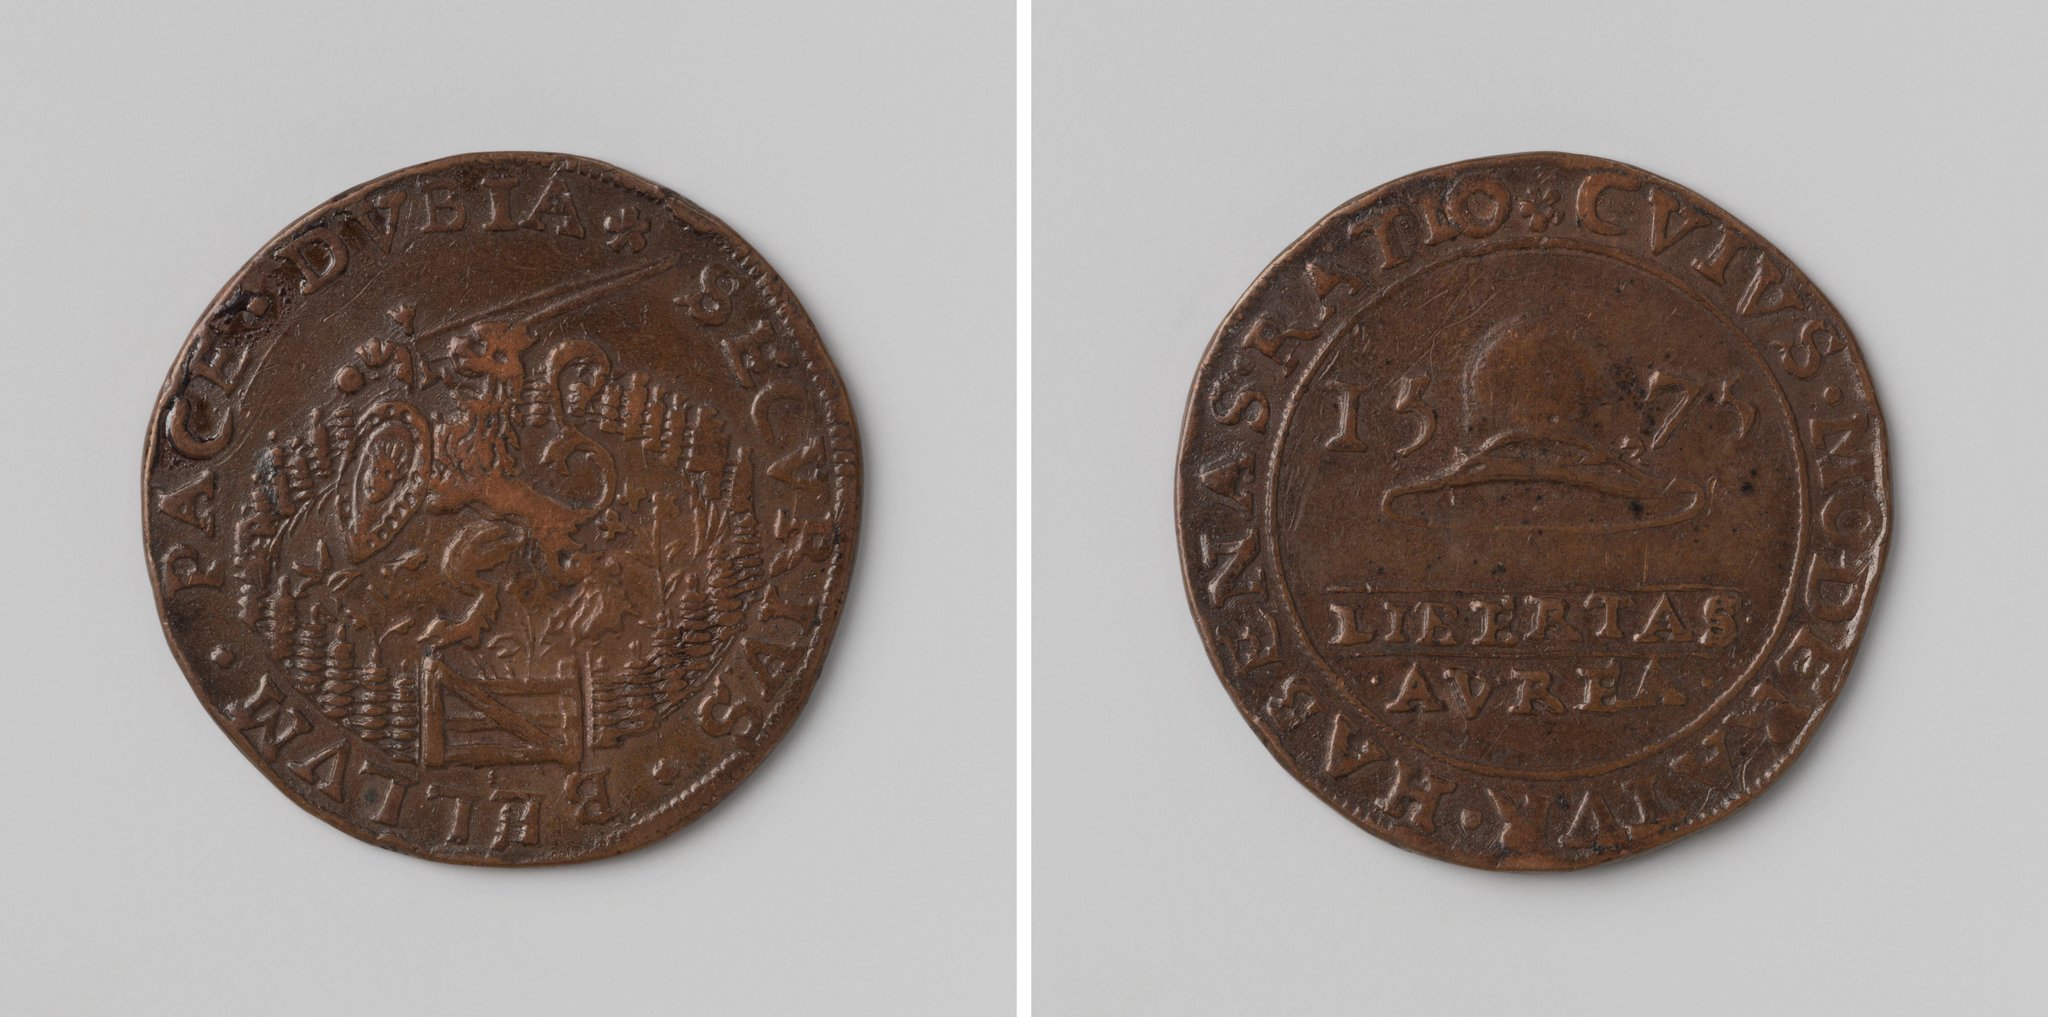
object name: jeton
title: Mislukte vredesonderhandelingen te Breda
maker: Anonymous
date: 1575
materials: copper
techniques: striking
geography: dordrecht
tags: breda, tachtigjarige oorlog, vredesonderhandelingen te breda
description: Koperen penning. Voorzijde: Nederlandse leeuw met zwaard en schild temidden van bloemen in omheinde tuin binnen omschrift. Keerzijde: vrijheidshoed tussen jaartal boven opschrift binnen omschrift